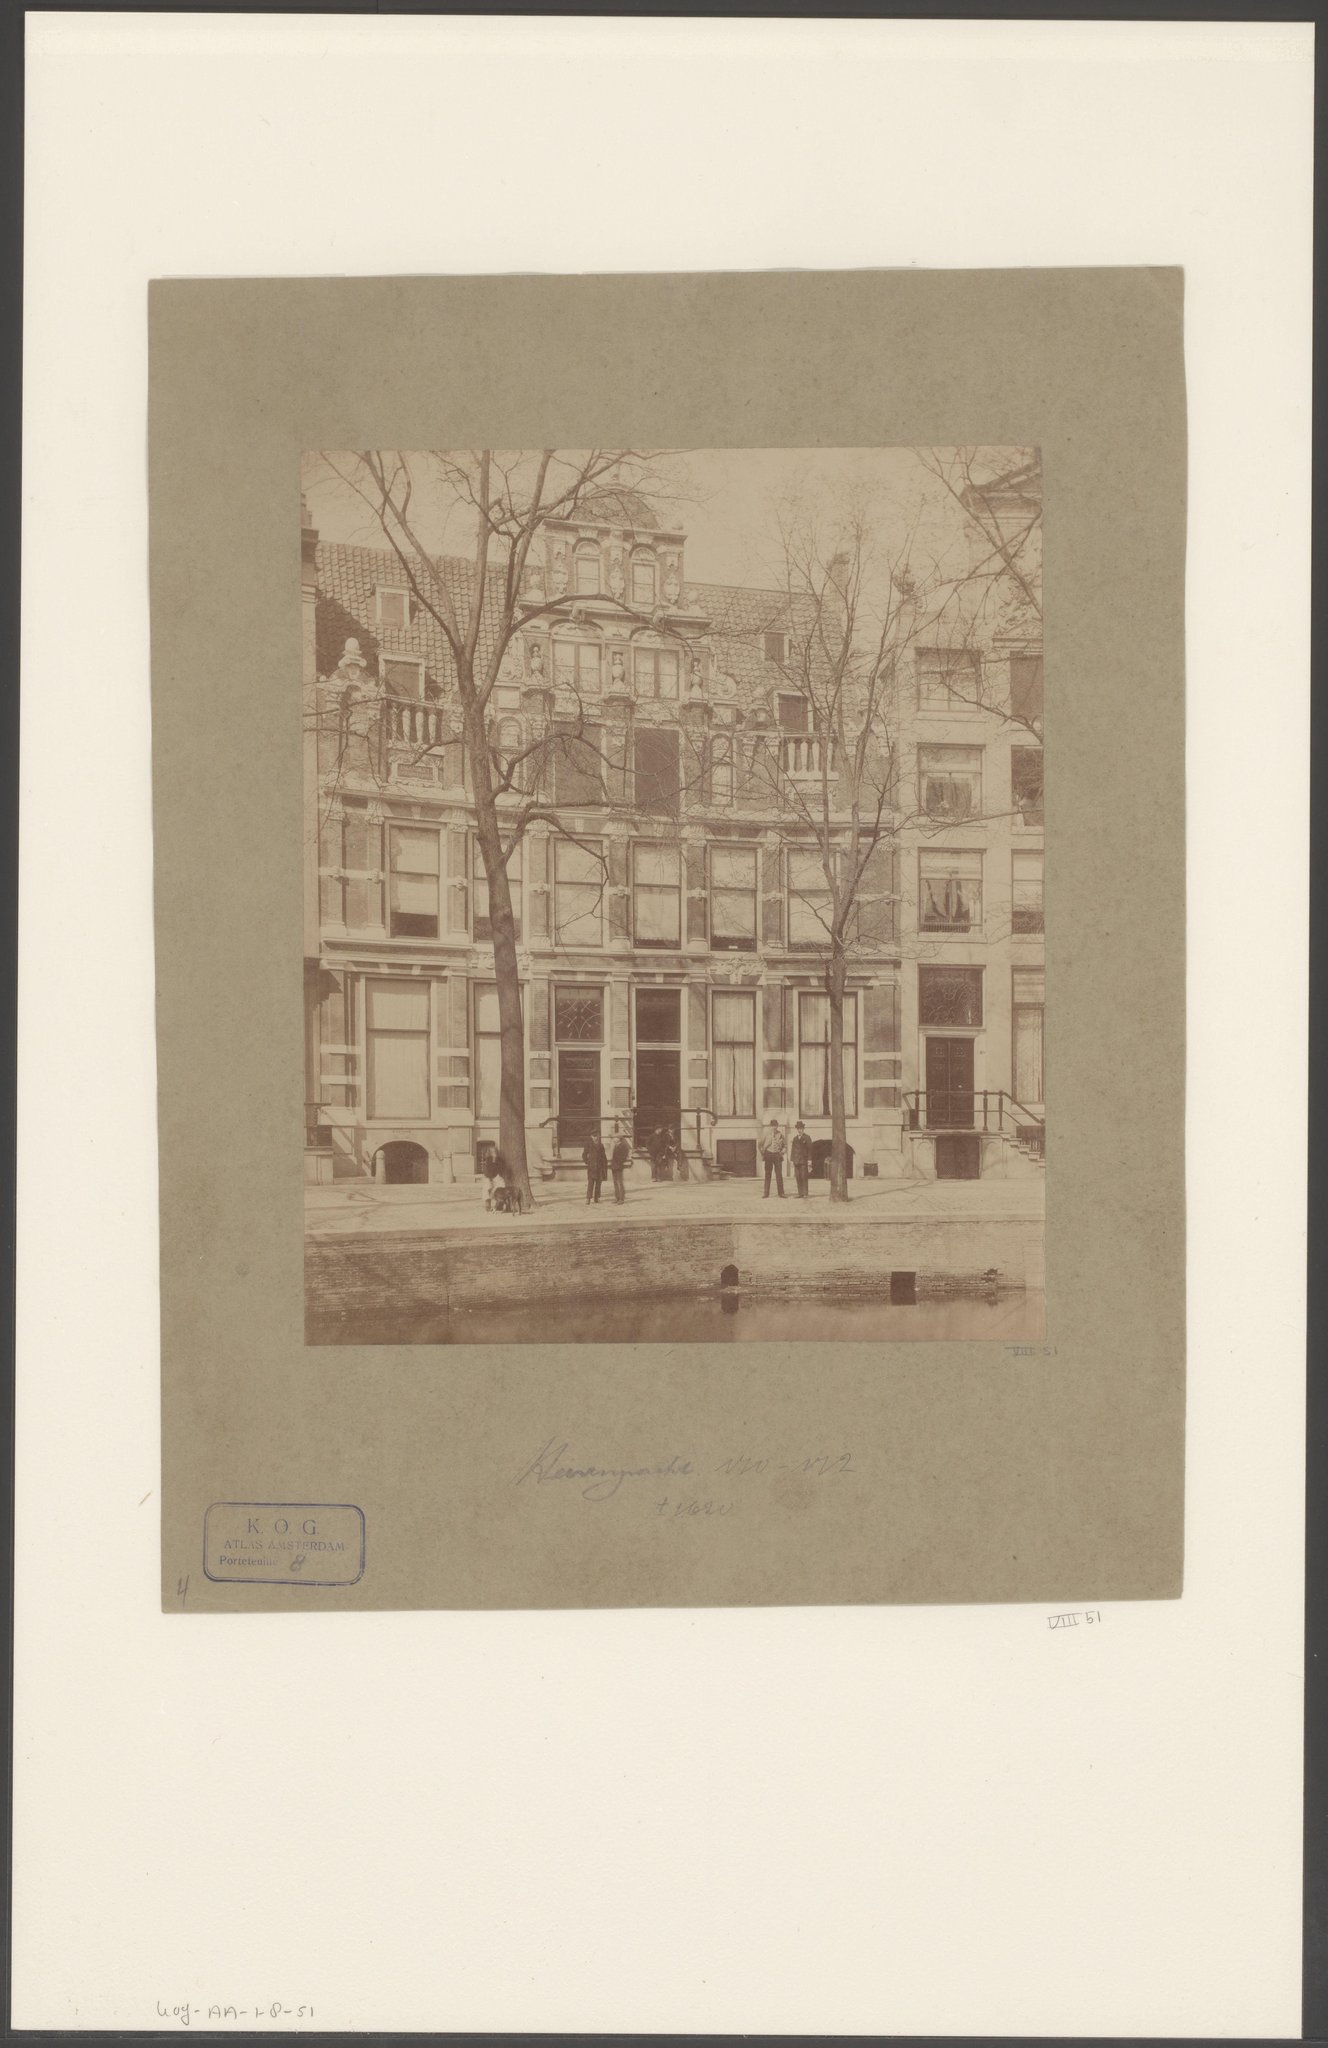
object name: photograph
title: Gezicht op enkele panden aan de Herengracht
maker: Anonymous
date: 1860-1920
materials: cardboard, paper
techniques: albumen print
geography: amsterdam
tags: city-view in general; 'veduta', canal, the usual house or row of houses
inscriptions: collector's mark: ‘8’ Lugt 1641b, inscription: ‘Heerengracht [...] / +- 1[...]20’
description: Onderwerpsrubriek binnen de Atlas Amsterdam: Haarlemmerplein, Halvemaansteeg, Handboogstraat, Handelskade, Haringpakkerij, Hartenstraat, Hasseltsteeg (Dirk van), Heerengracht.